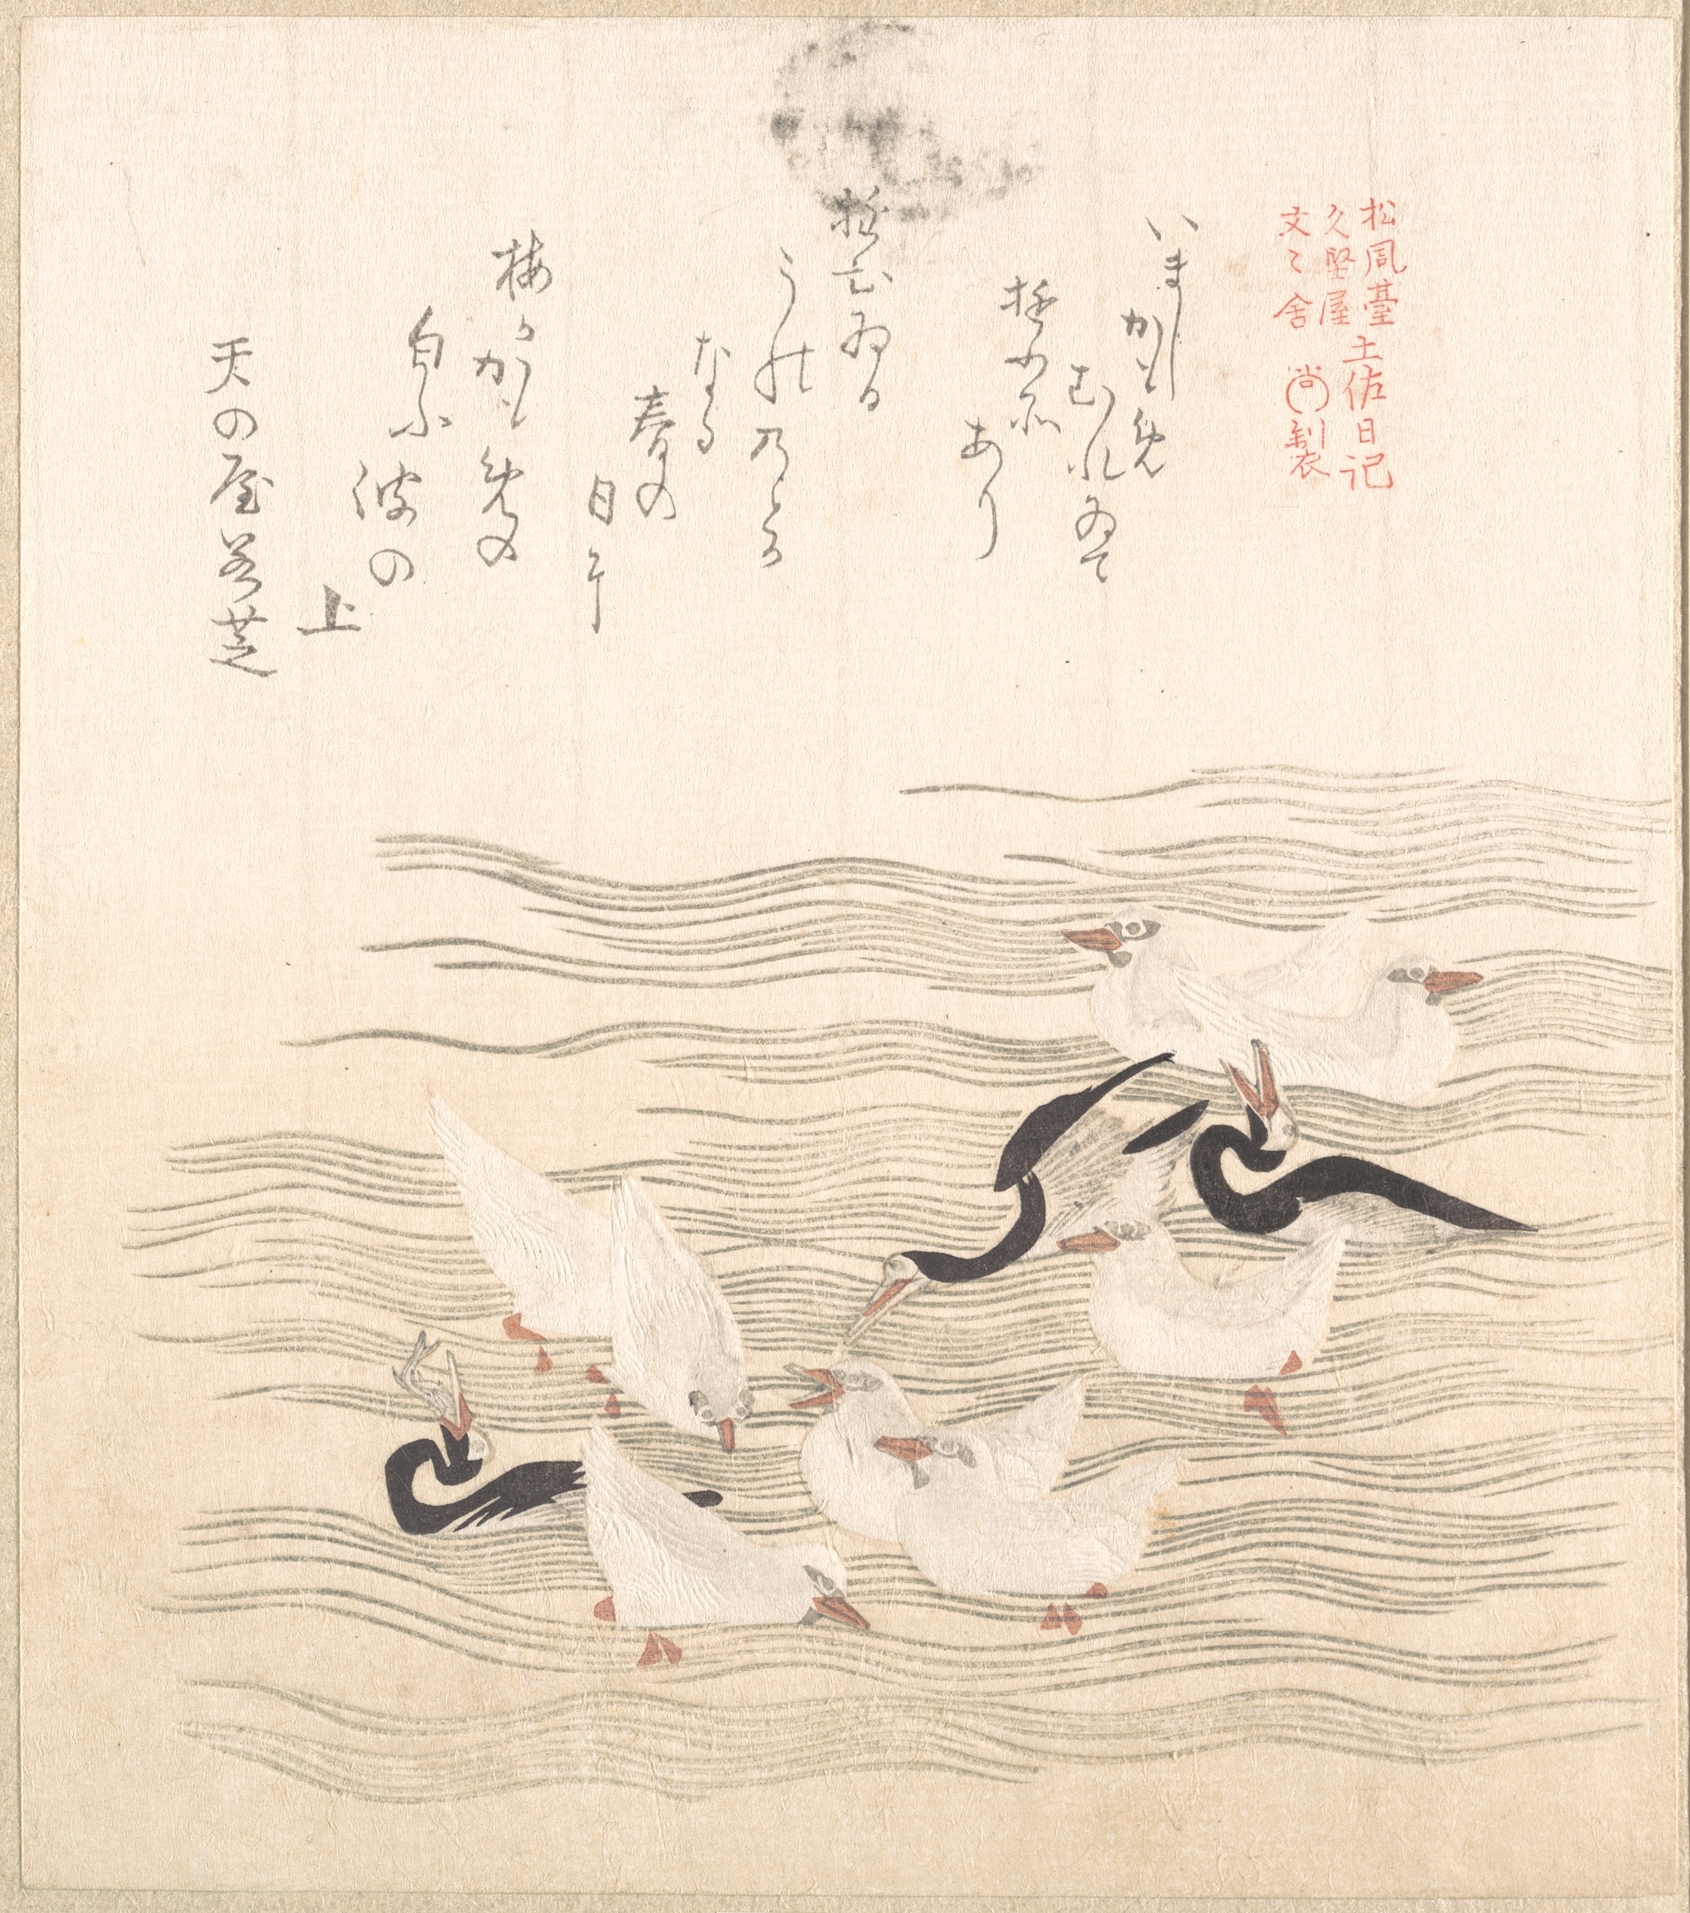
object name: print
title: Sea-Gulls Playing on the Water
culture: japanese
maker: kubo shunman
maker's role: artist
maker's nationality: japanese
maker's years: 1757-1820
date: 1801-1900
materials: ink, paper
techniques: surimono, woodblock print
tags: birds